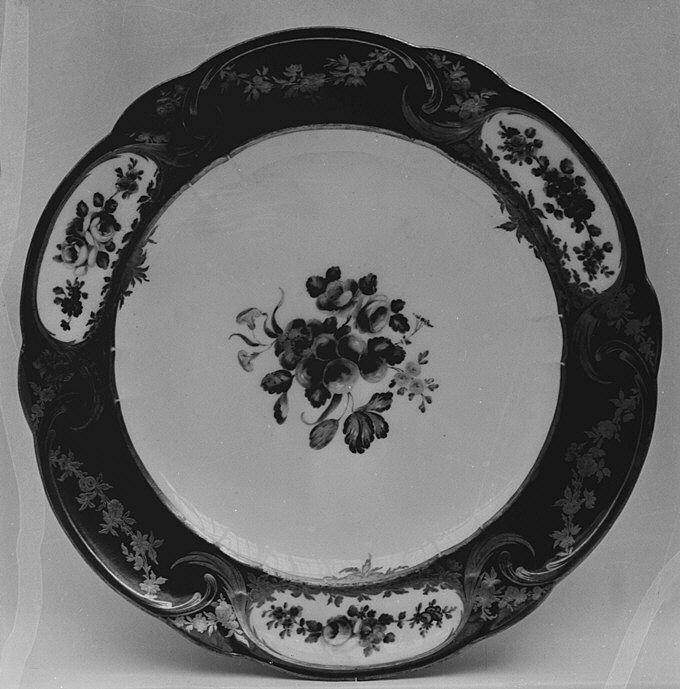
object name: plate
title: Plate (assiette à palmes) (1 of 102) (part of a service)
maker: sèvres manufactory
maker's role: manufactory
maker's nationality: french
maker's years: 1740-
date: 1767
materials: soft paste porcelain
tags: flowers